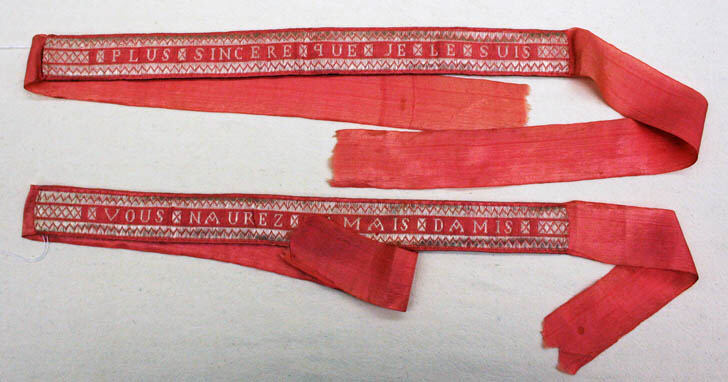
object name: garter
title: Garters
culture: french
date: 1790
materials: silk